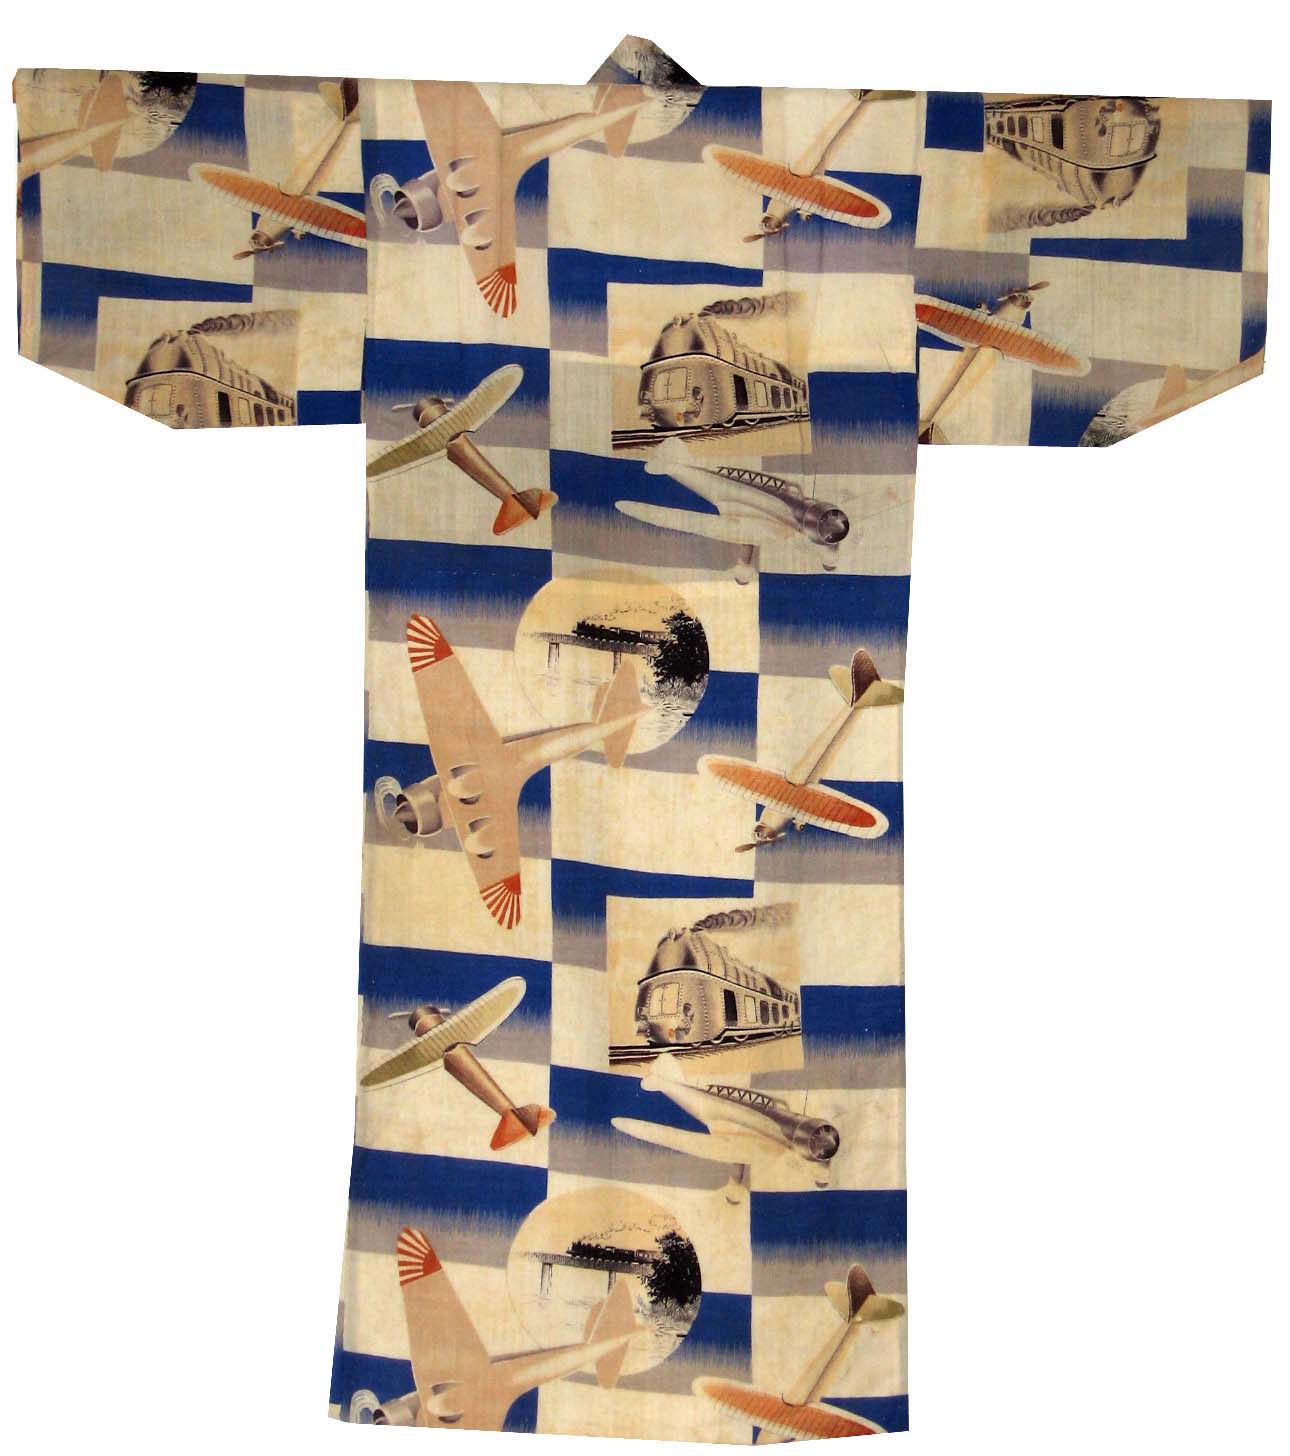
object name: kimono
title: Boy’s Kimono with Streamline Train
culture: japanese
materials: wool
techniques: weave, printing